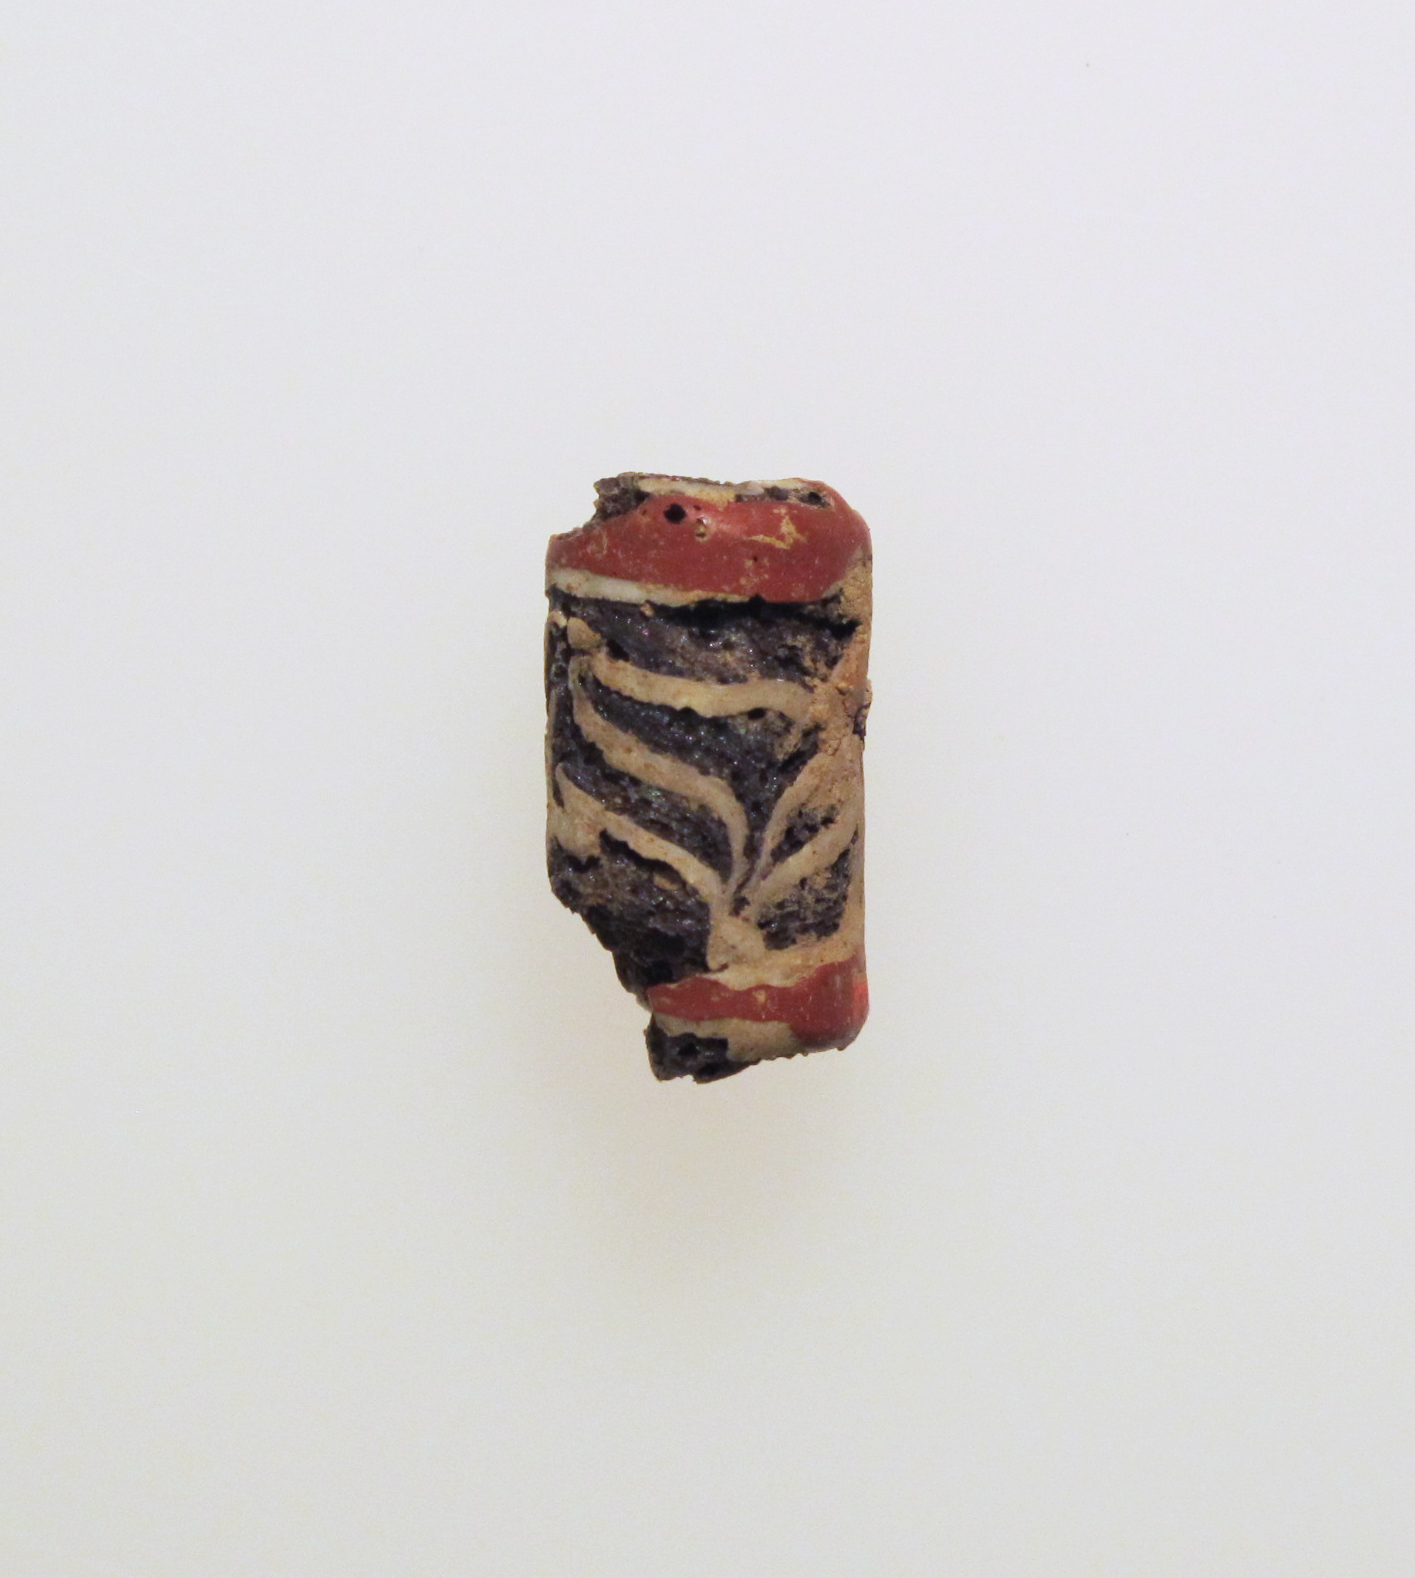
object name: bead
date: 7000 BCE-330 CE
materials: glass